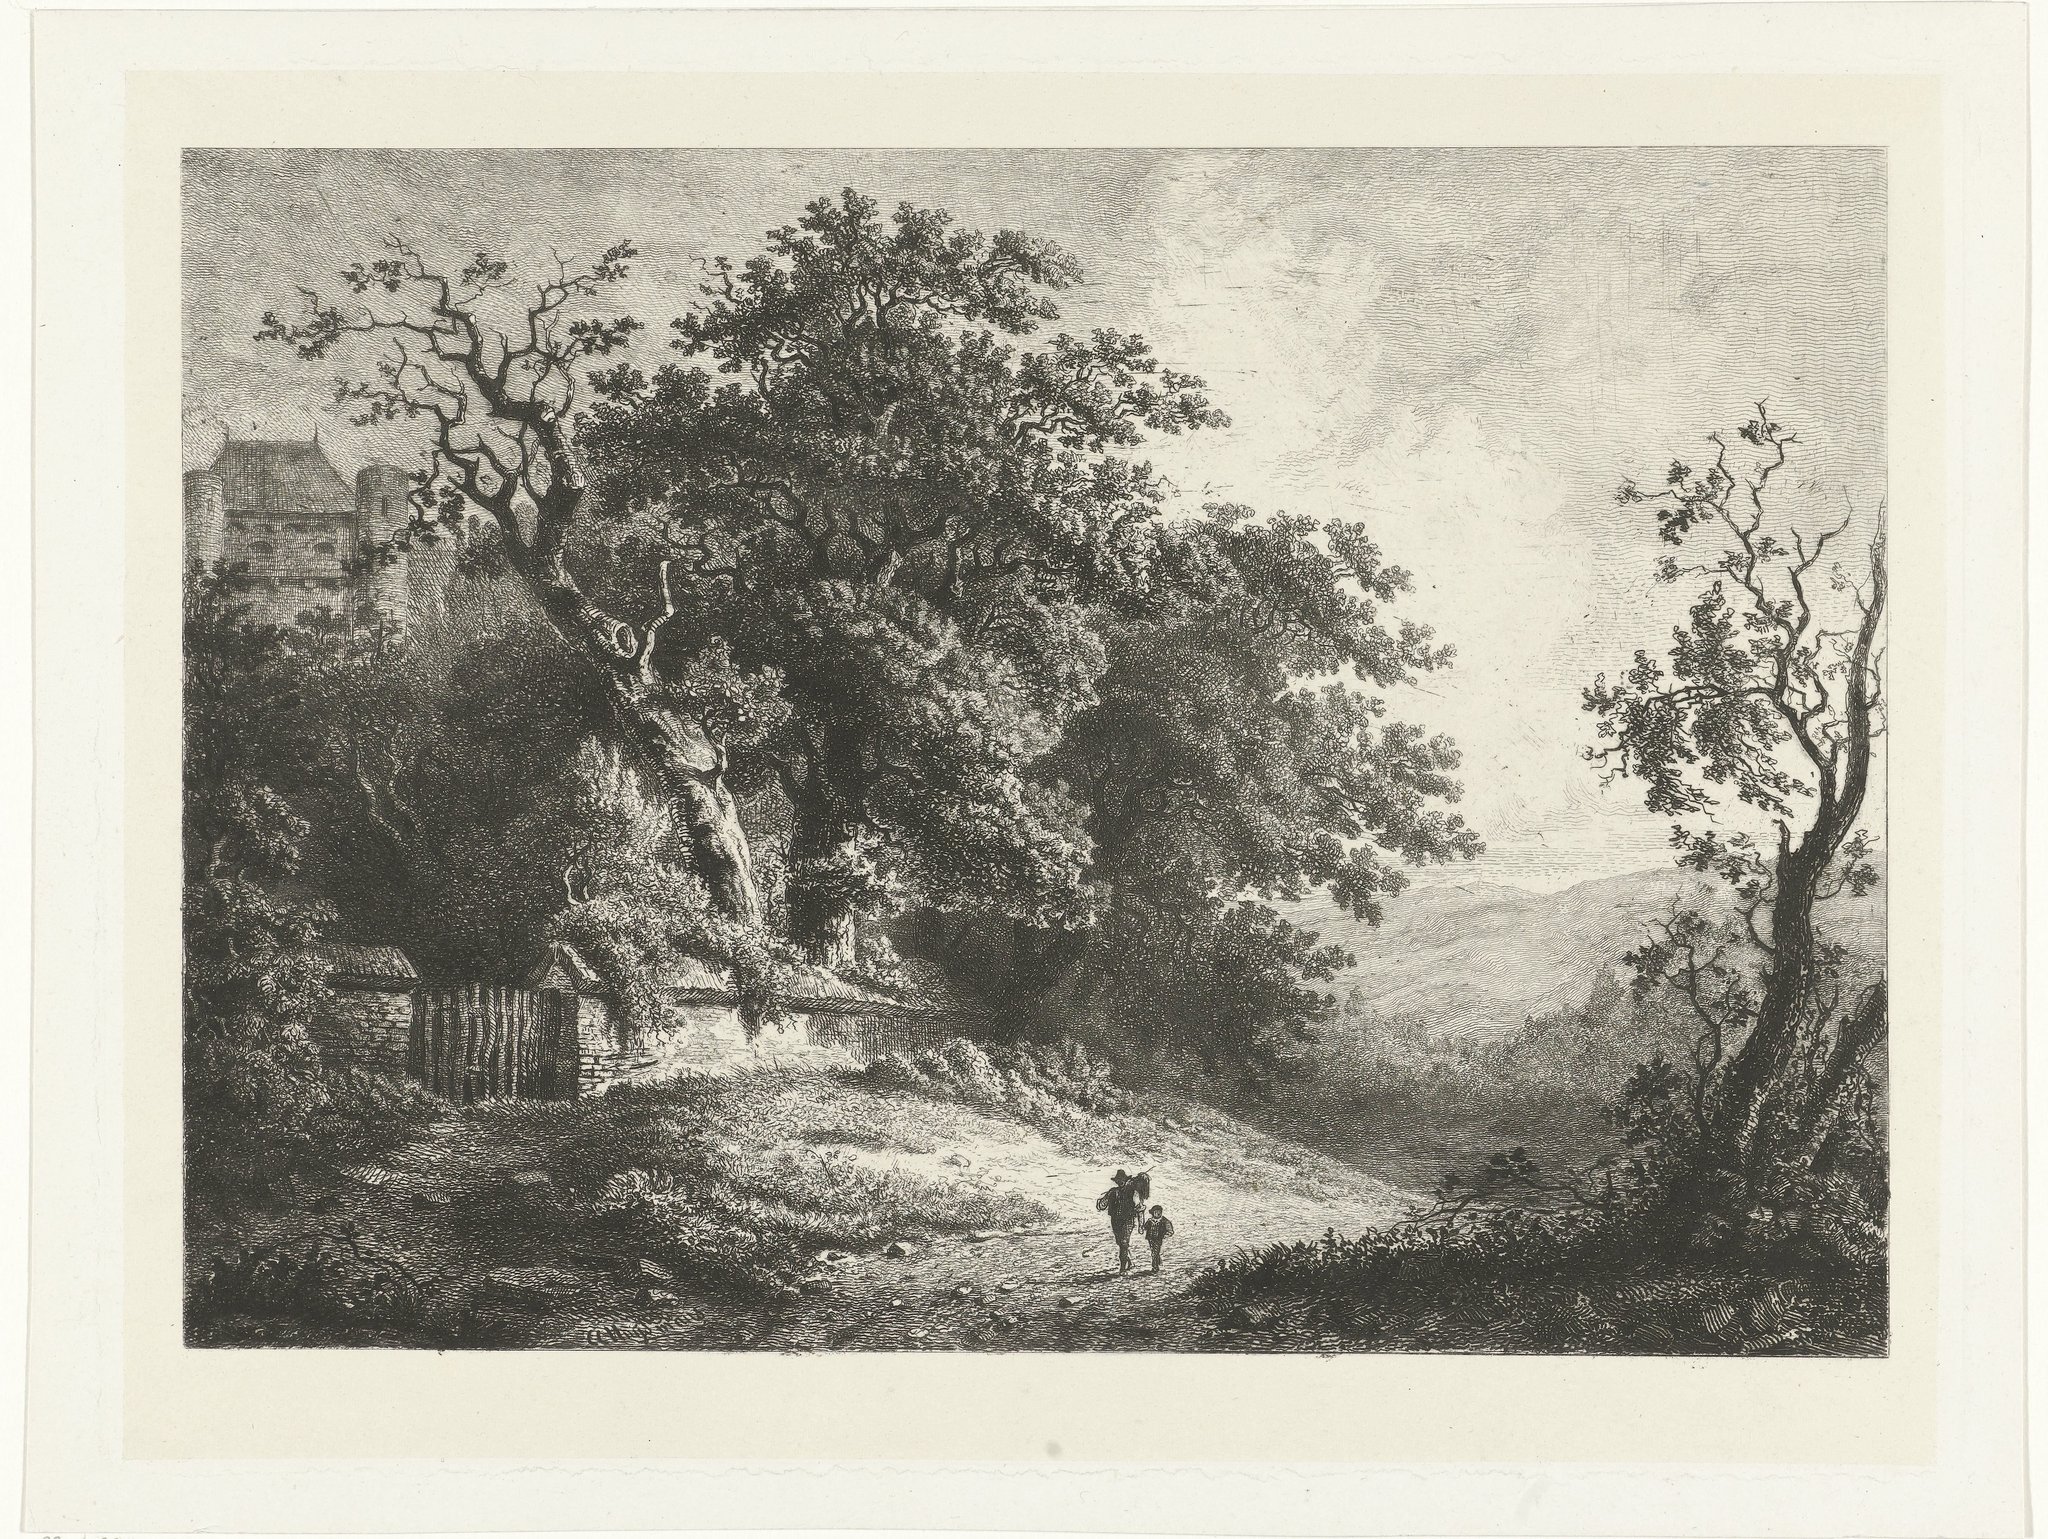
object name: print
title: Landschap met bomen en kasteel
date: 1820-1886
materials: paper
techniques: etching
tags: castle, landscapes in the temperate zone (+ landscape with figures, staffage)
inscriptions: collector's mark: Lugt 2228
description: Een man en jongen wandelen op een weg. Links een muur met hek, bomen en een kasteel.